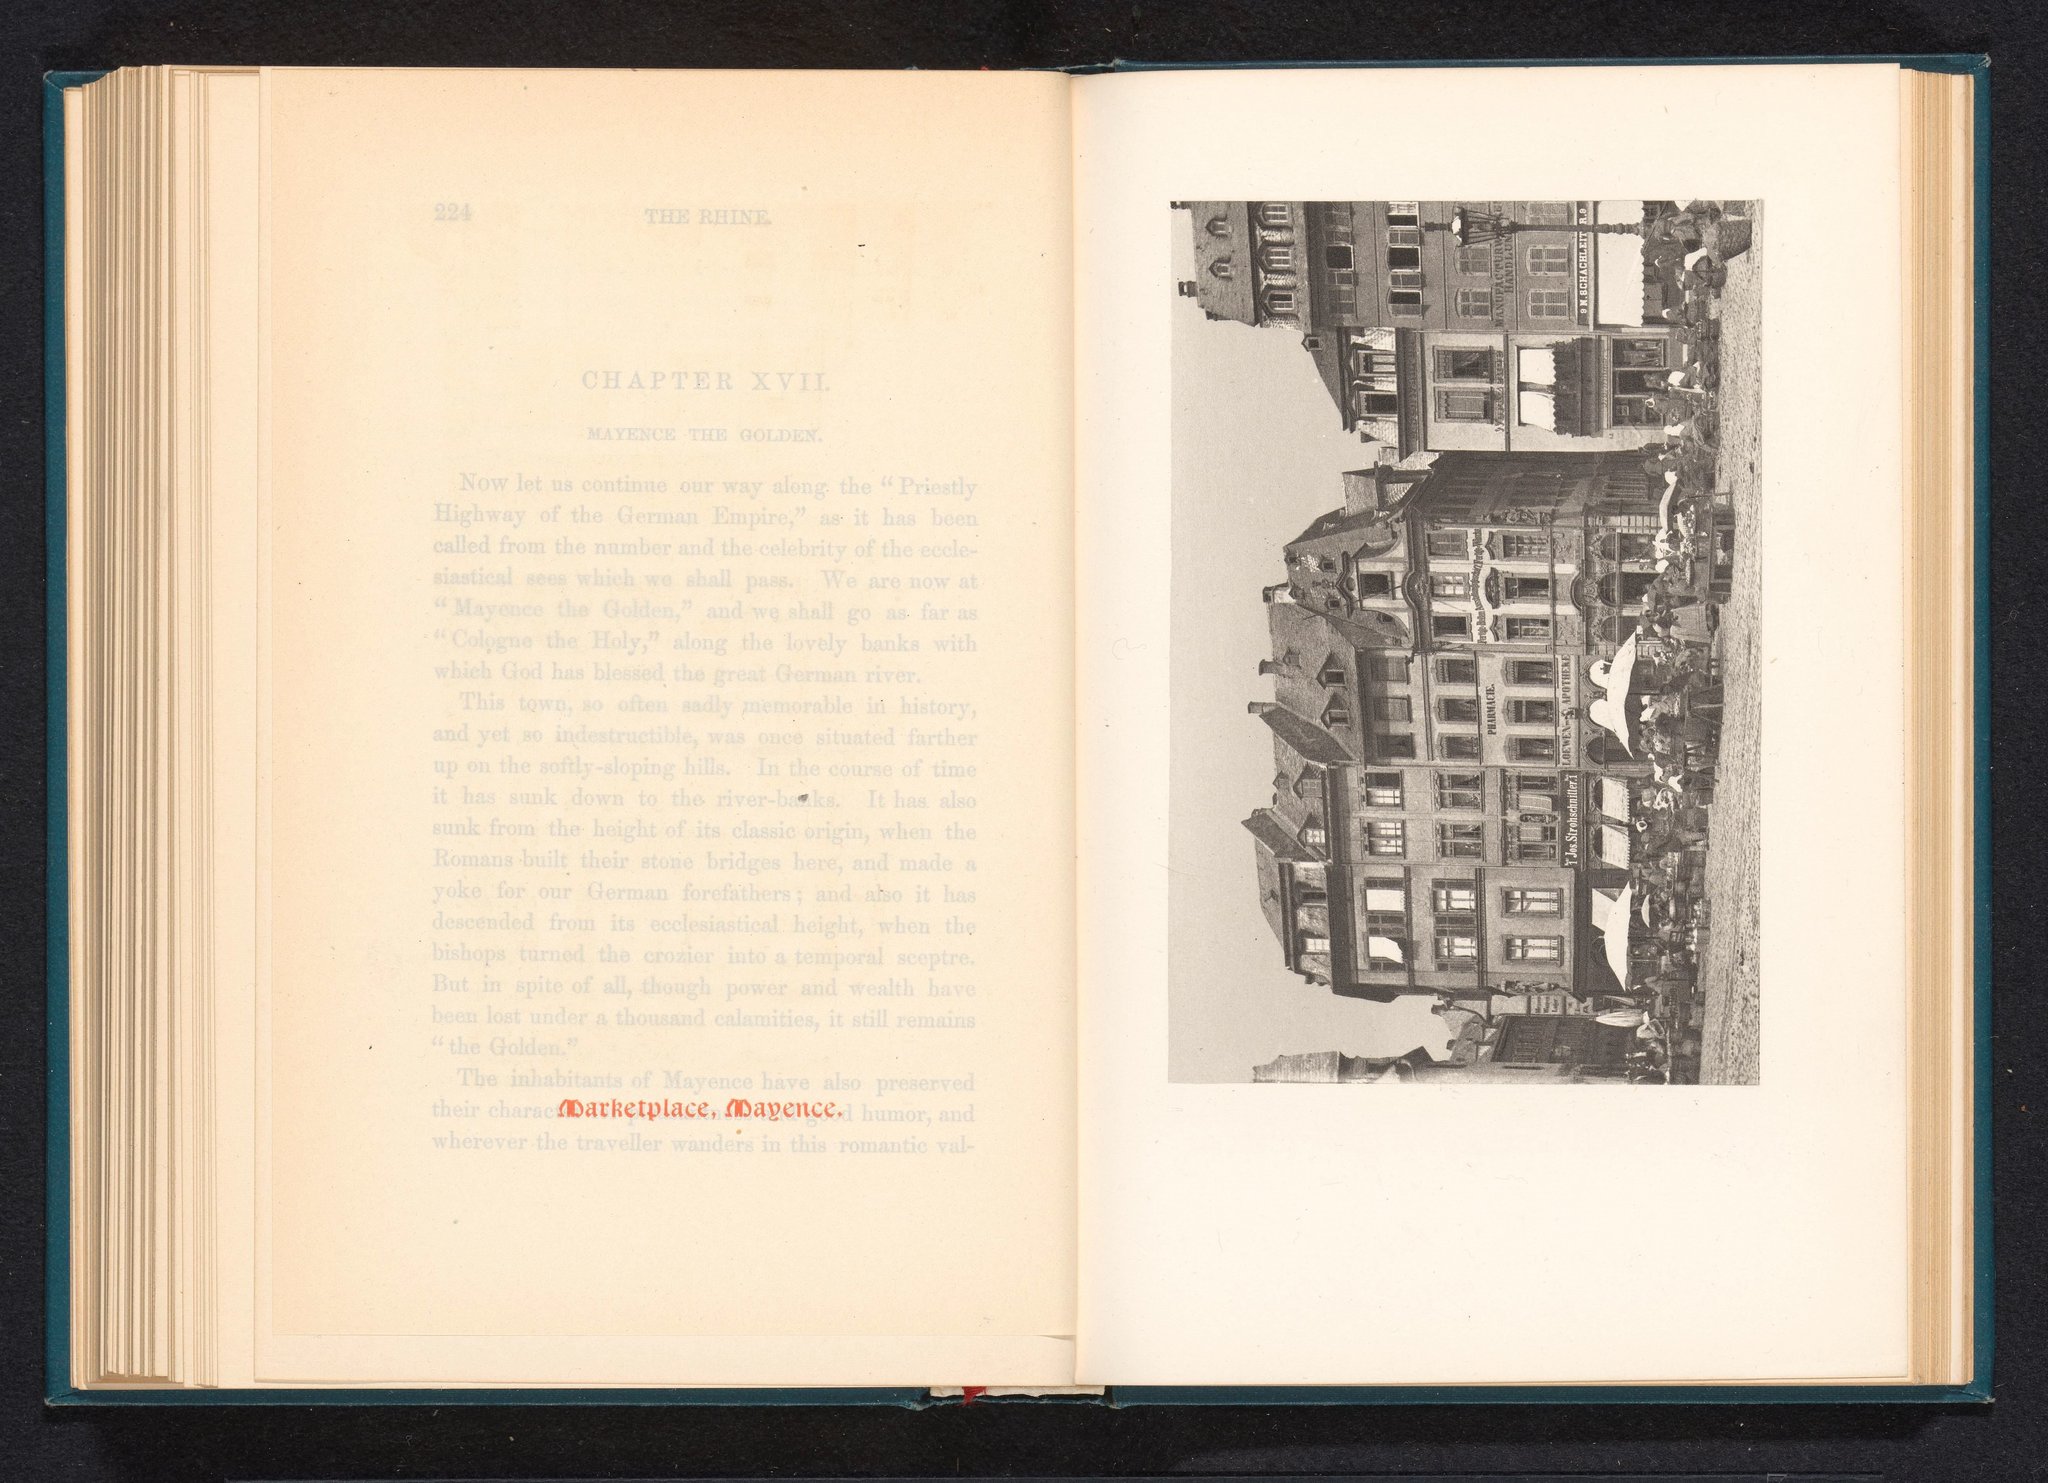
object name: page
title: Markt te Mainz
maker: Anonymous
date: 1889-1899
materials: paper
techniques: photoaquatint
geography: markt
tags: square, place, circus, etc., market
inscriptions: title: ‘Marketplace, Mayence.’